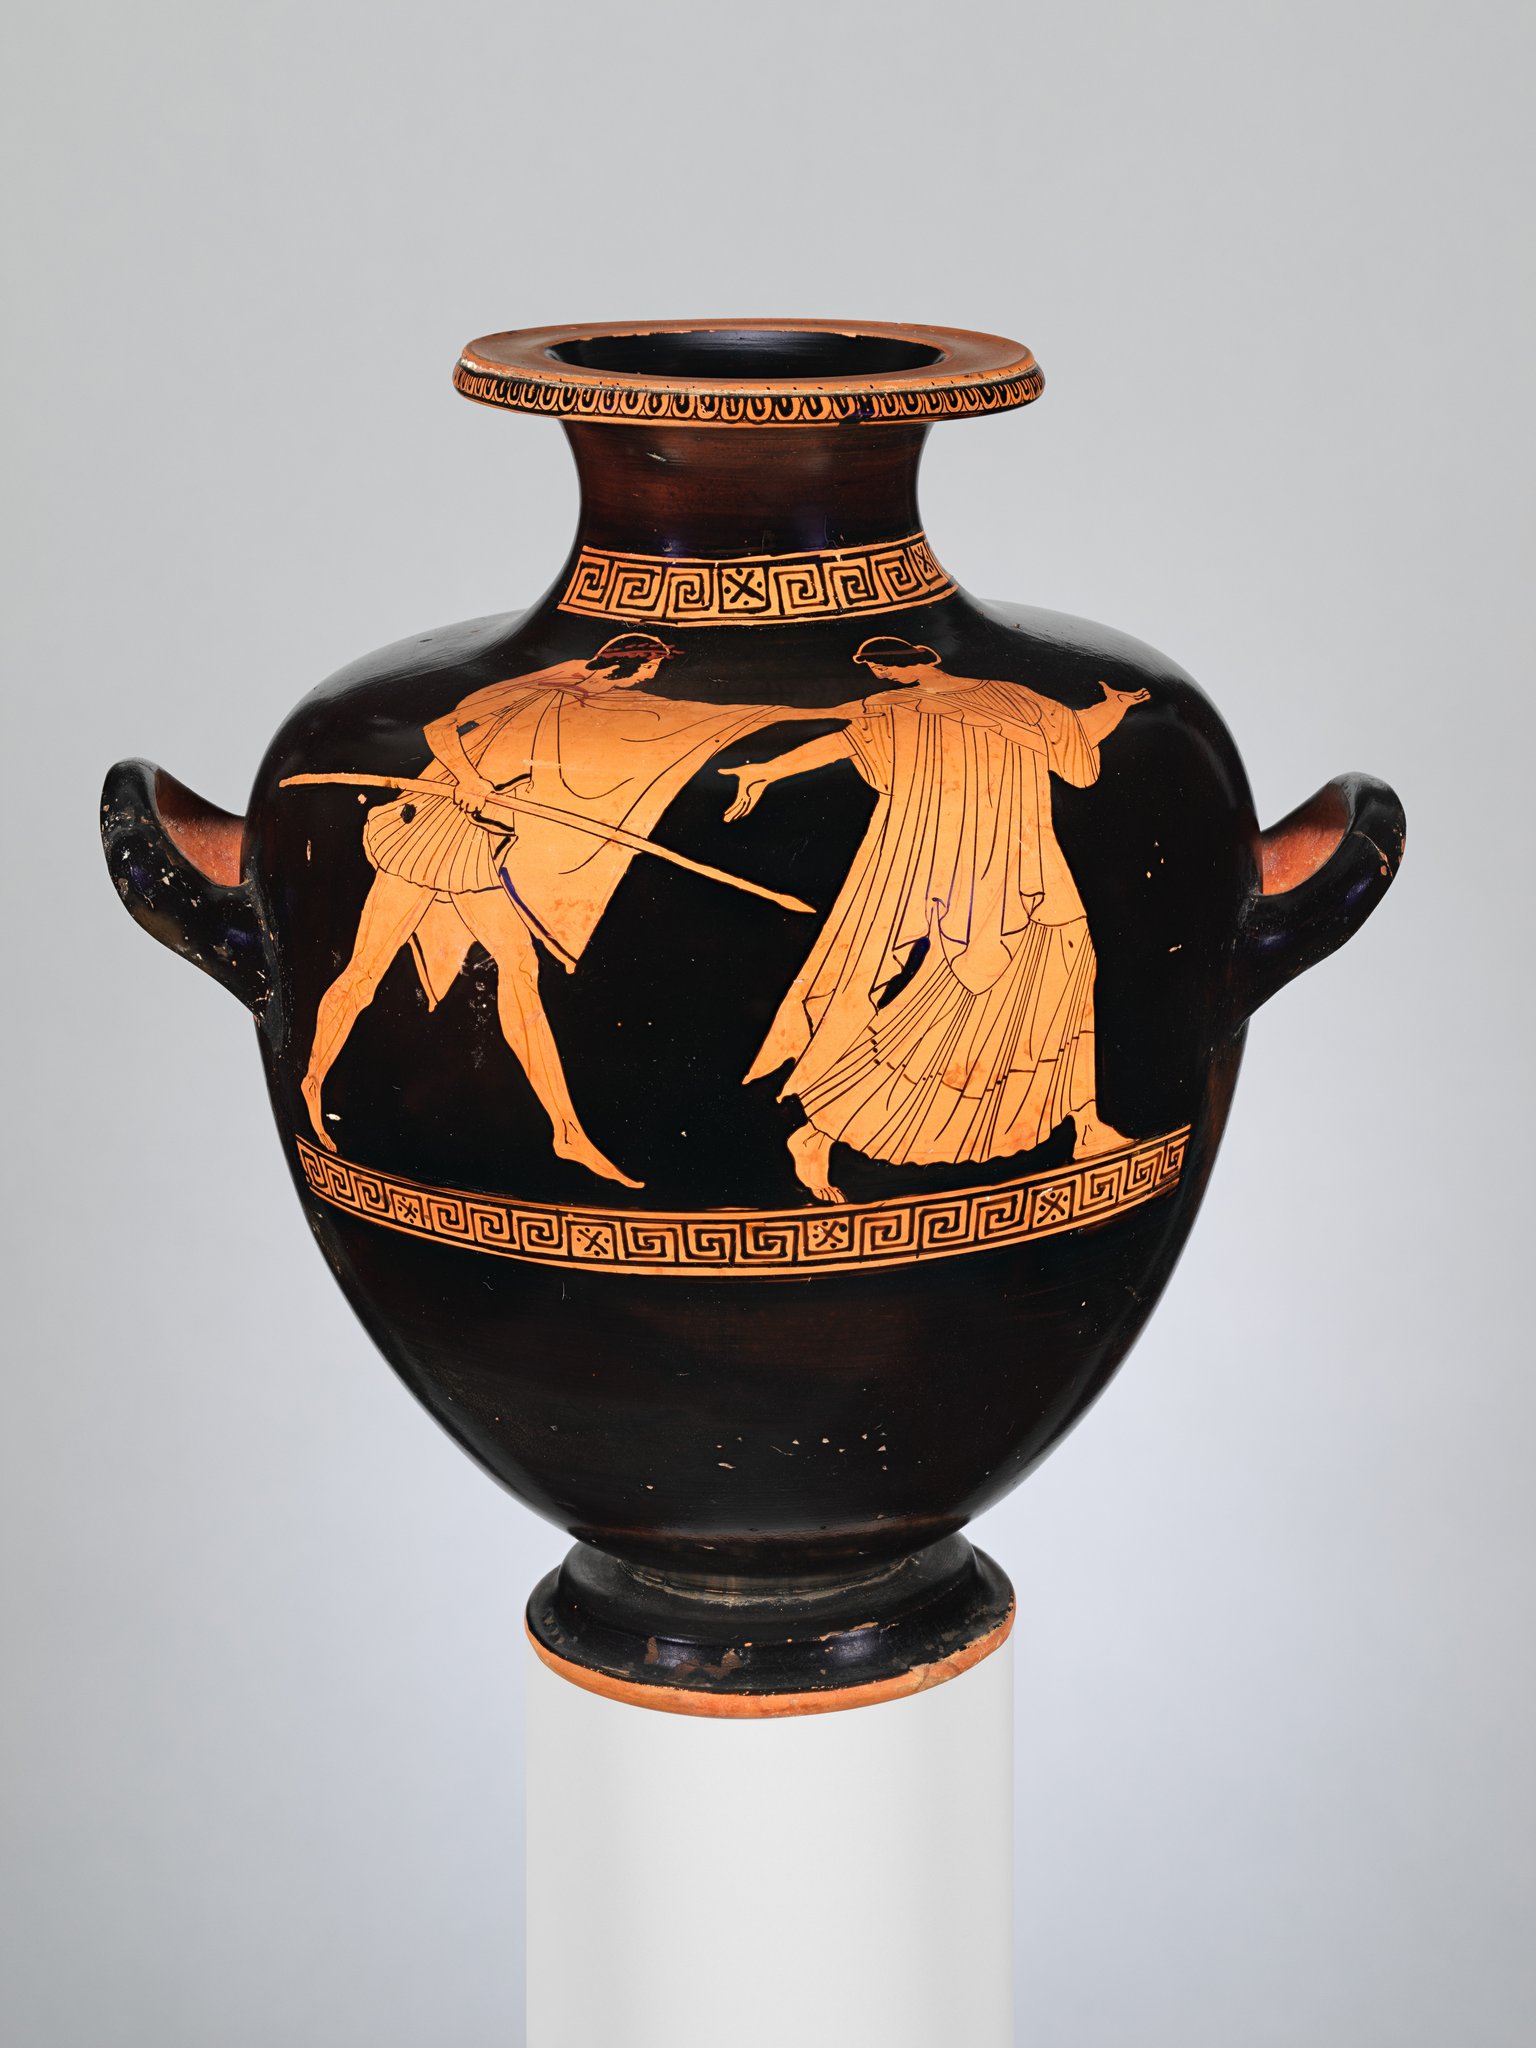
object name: hydria, kalpis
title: Terracotta hydria: kalpis (water jar)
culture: greek, attic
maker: achilles painter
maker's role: artist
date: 450-440 BCE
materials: terracotta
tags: men,women